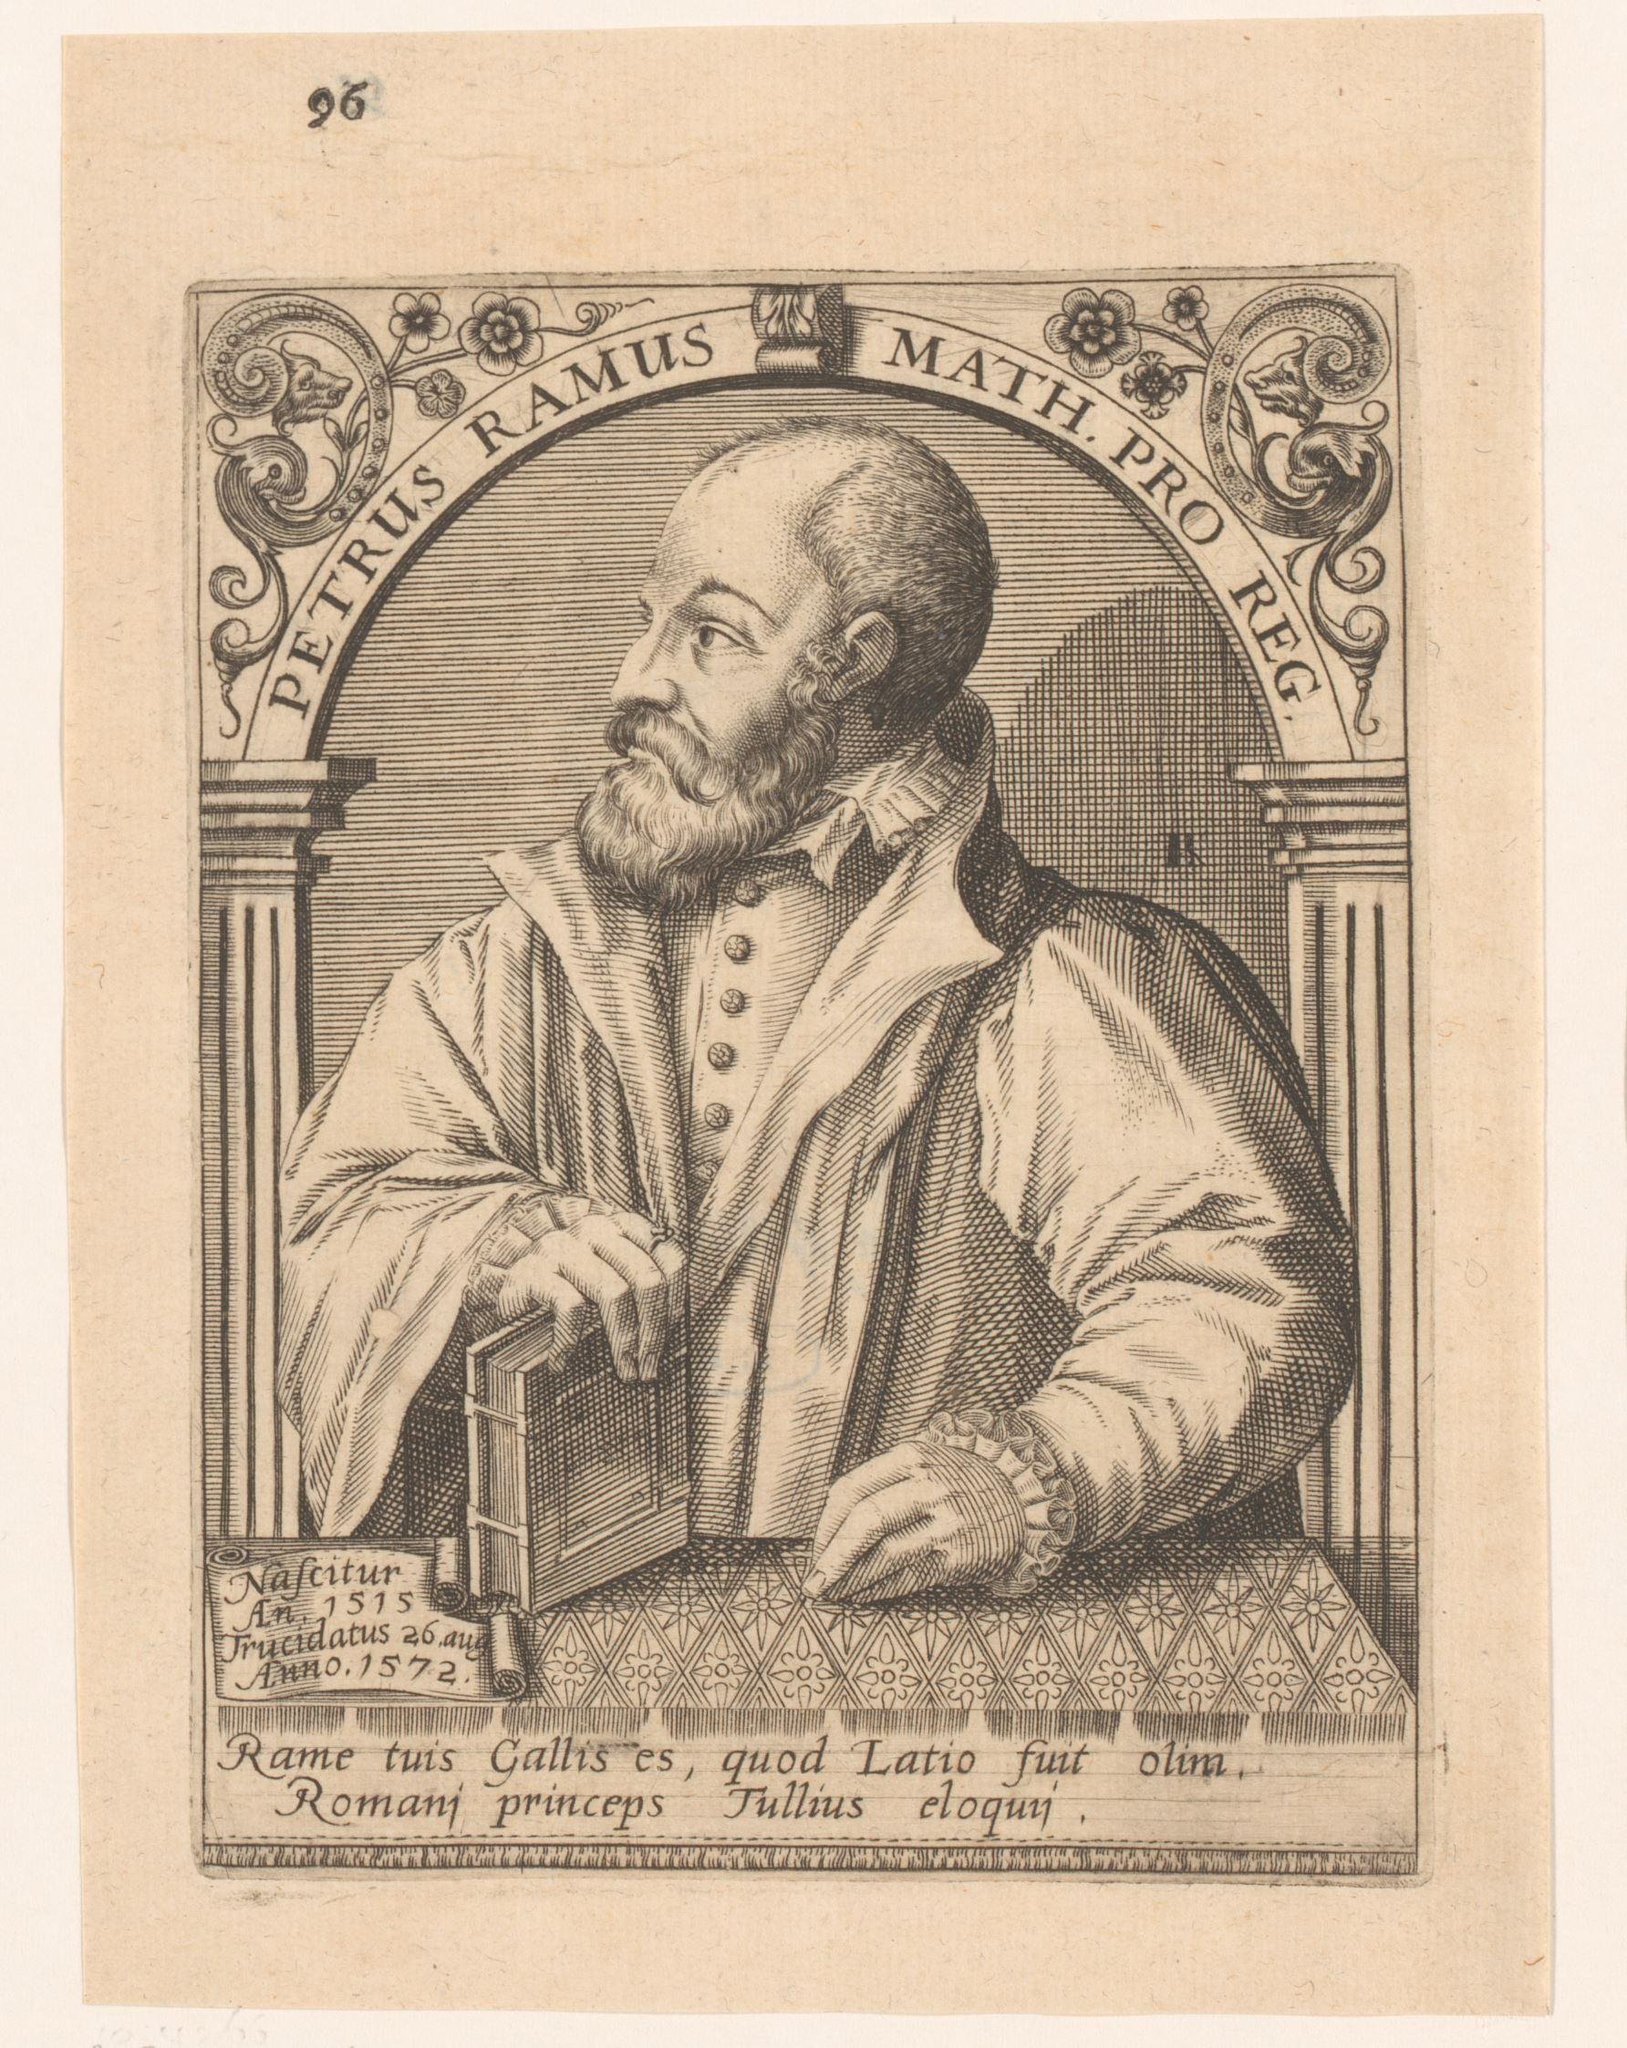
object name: book illustration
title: Petrus Ramus math. pro reg.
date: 1597-1599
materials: paper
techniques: engraving, letterpress printing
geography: france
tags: paris, historical persons, book, swimming mammals: dolphin - ff - fabulous animals (sometimes wrongly called 'grotesques'); 'mostri' (ripa)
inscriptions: collector's mark: Lugt 2228